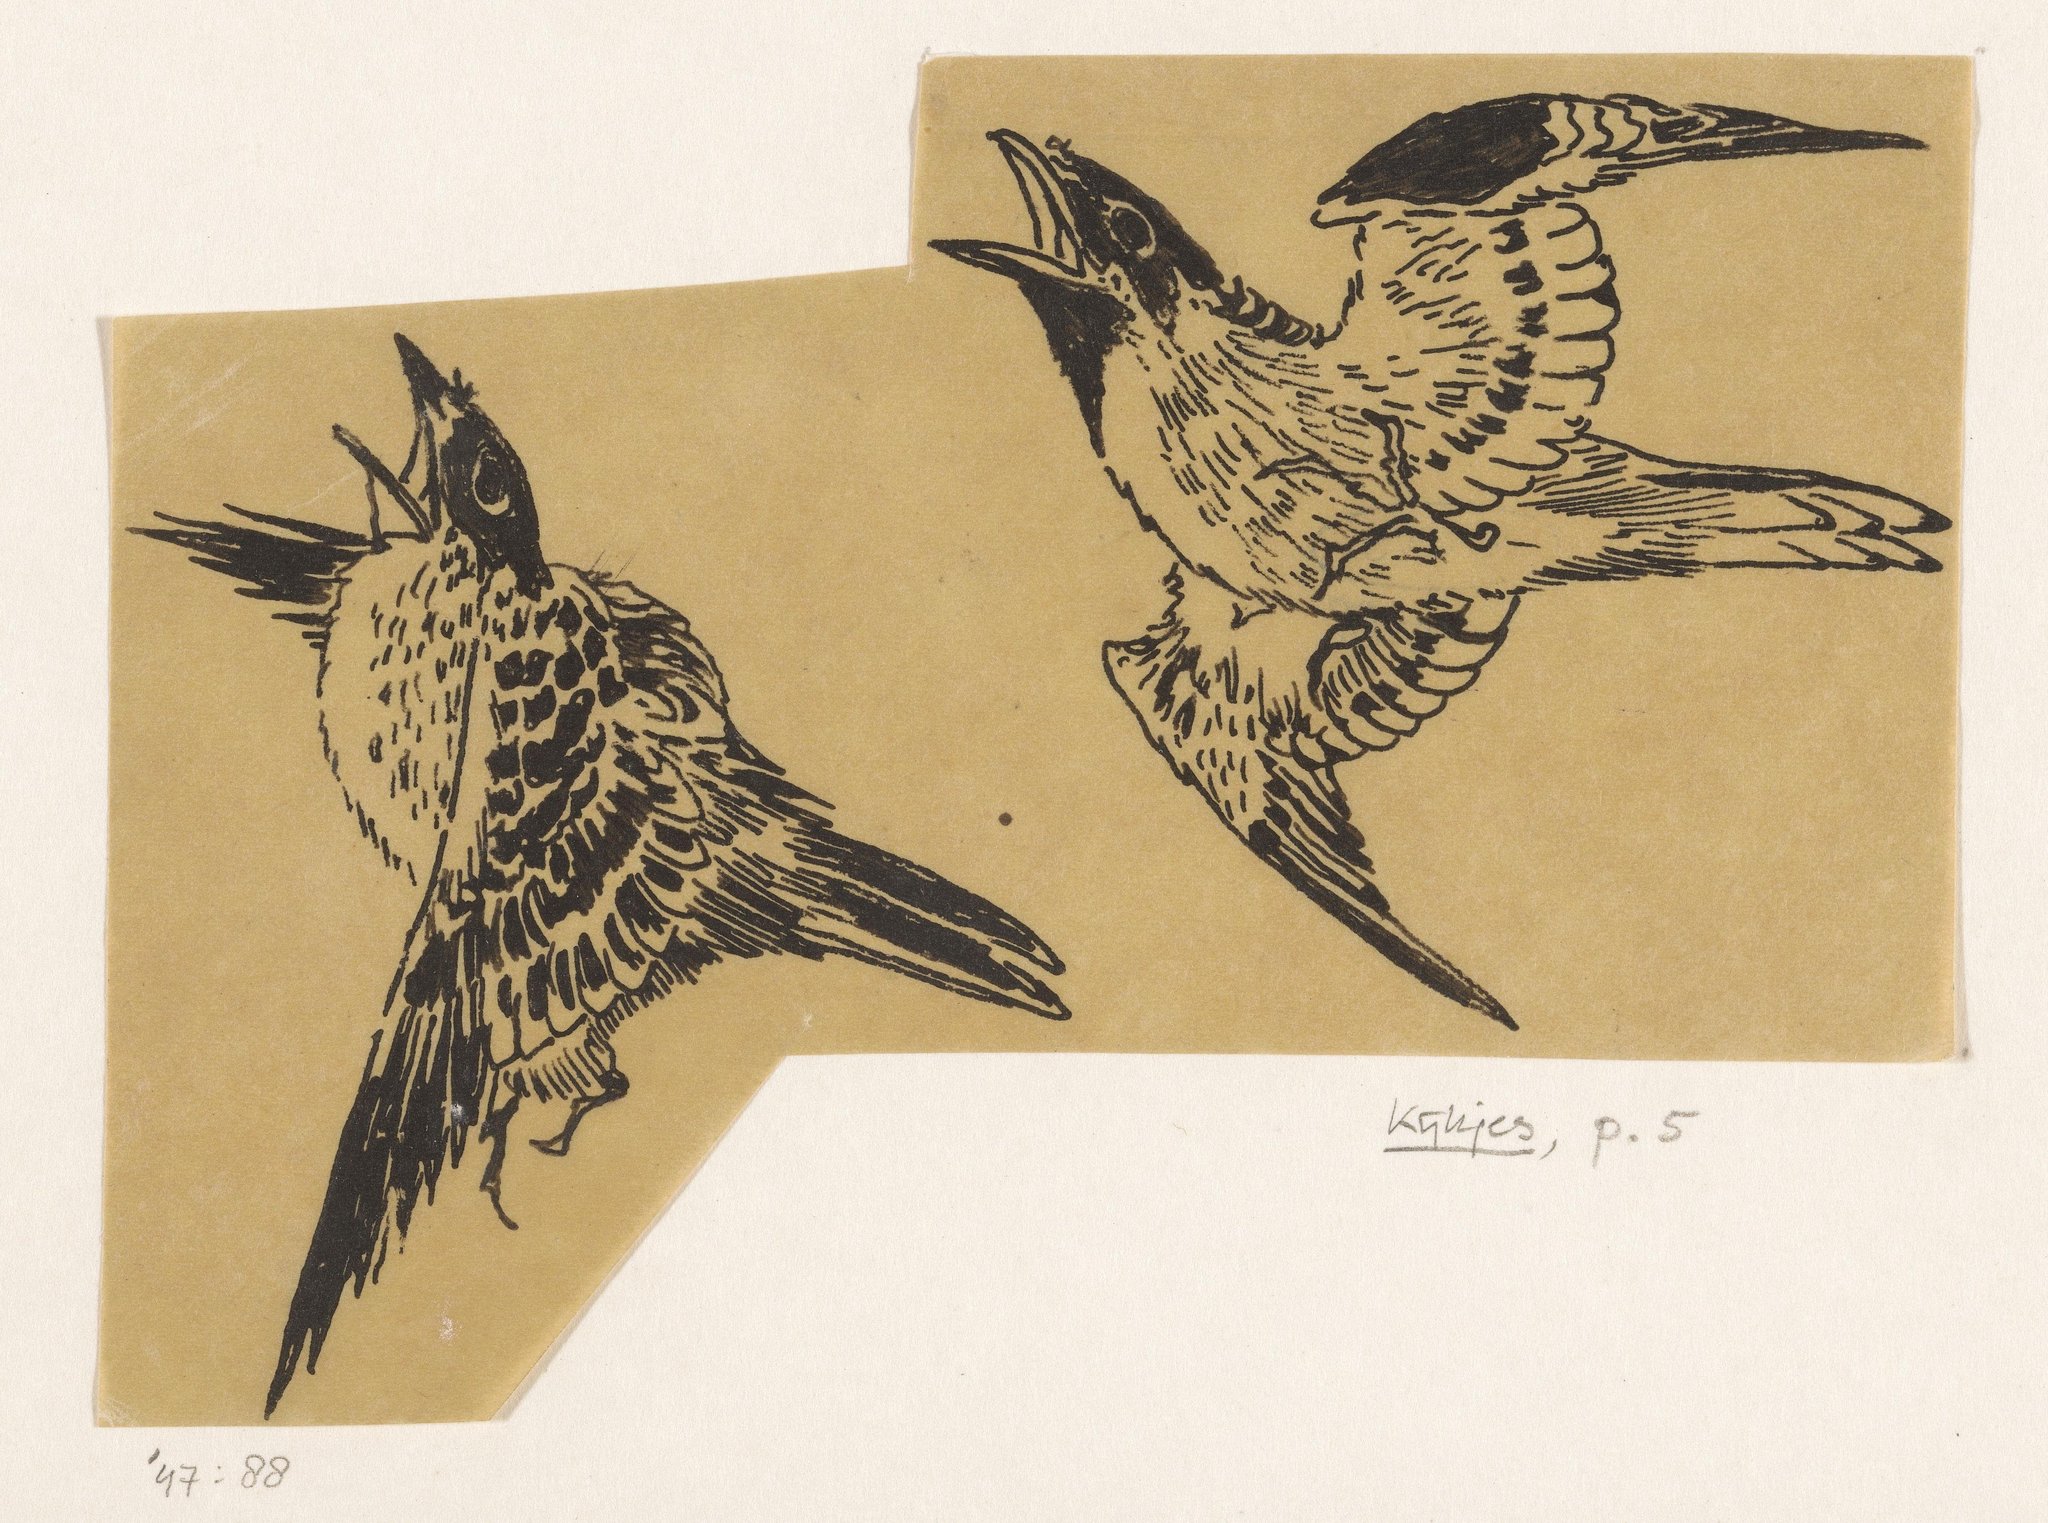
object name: boekillustratie ontwerp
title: Leeuweriken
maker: willem wenckebach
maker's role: designer, draughtsman, painter, print maker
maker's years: 1860-1937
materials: ink, paper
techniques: pen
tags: song-birds: lark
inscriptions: collector's mark: Lugt 2228a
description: Ontwerp voor: Knappert, Emilie C. Kijkjes in de plantenwereld. Loman & Funke: Amsterdam, 1893.